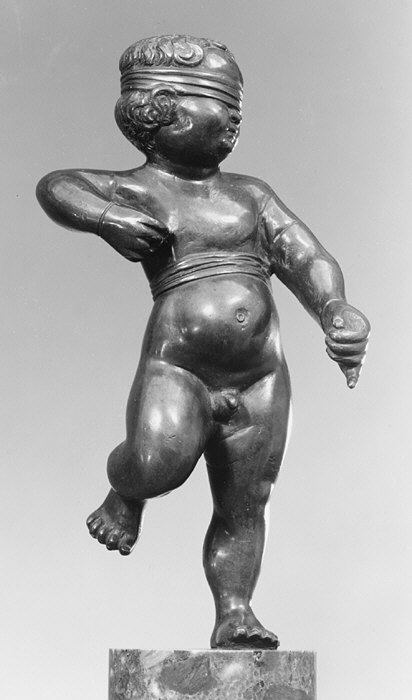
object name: statuette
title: Cupid Blindfolded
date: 1501-1600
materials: bronze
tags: cupid